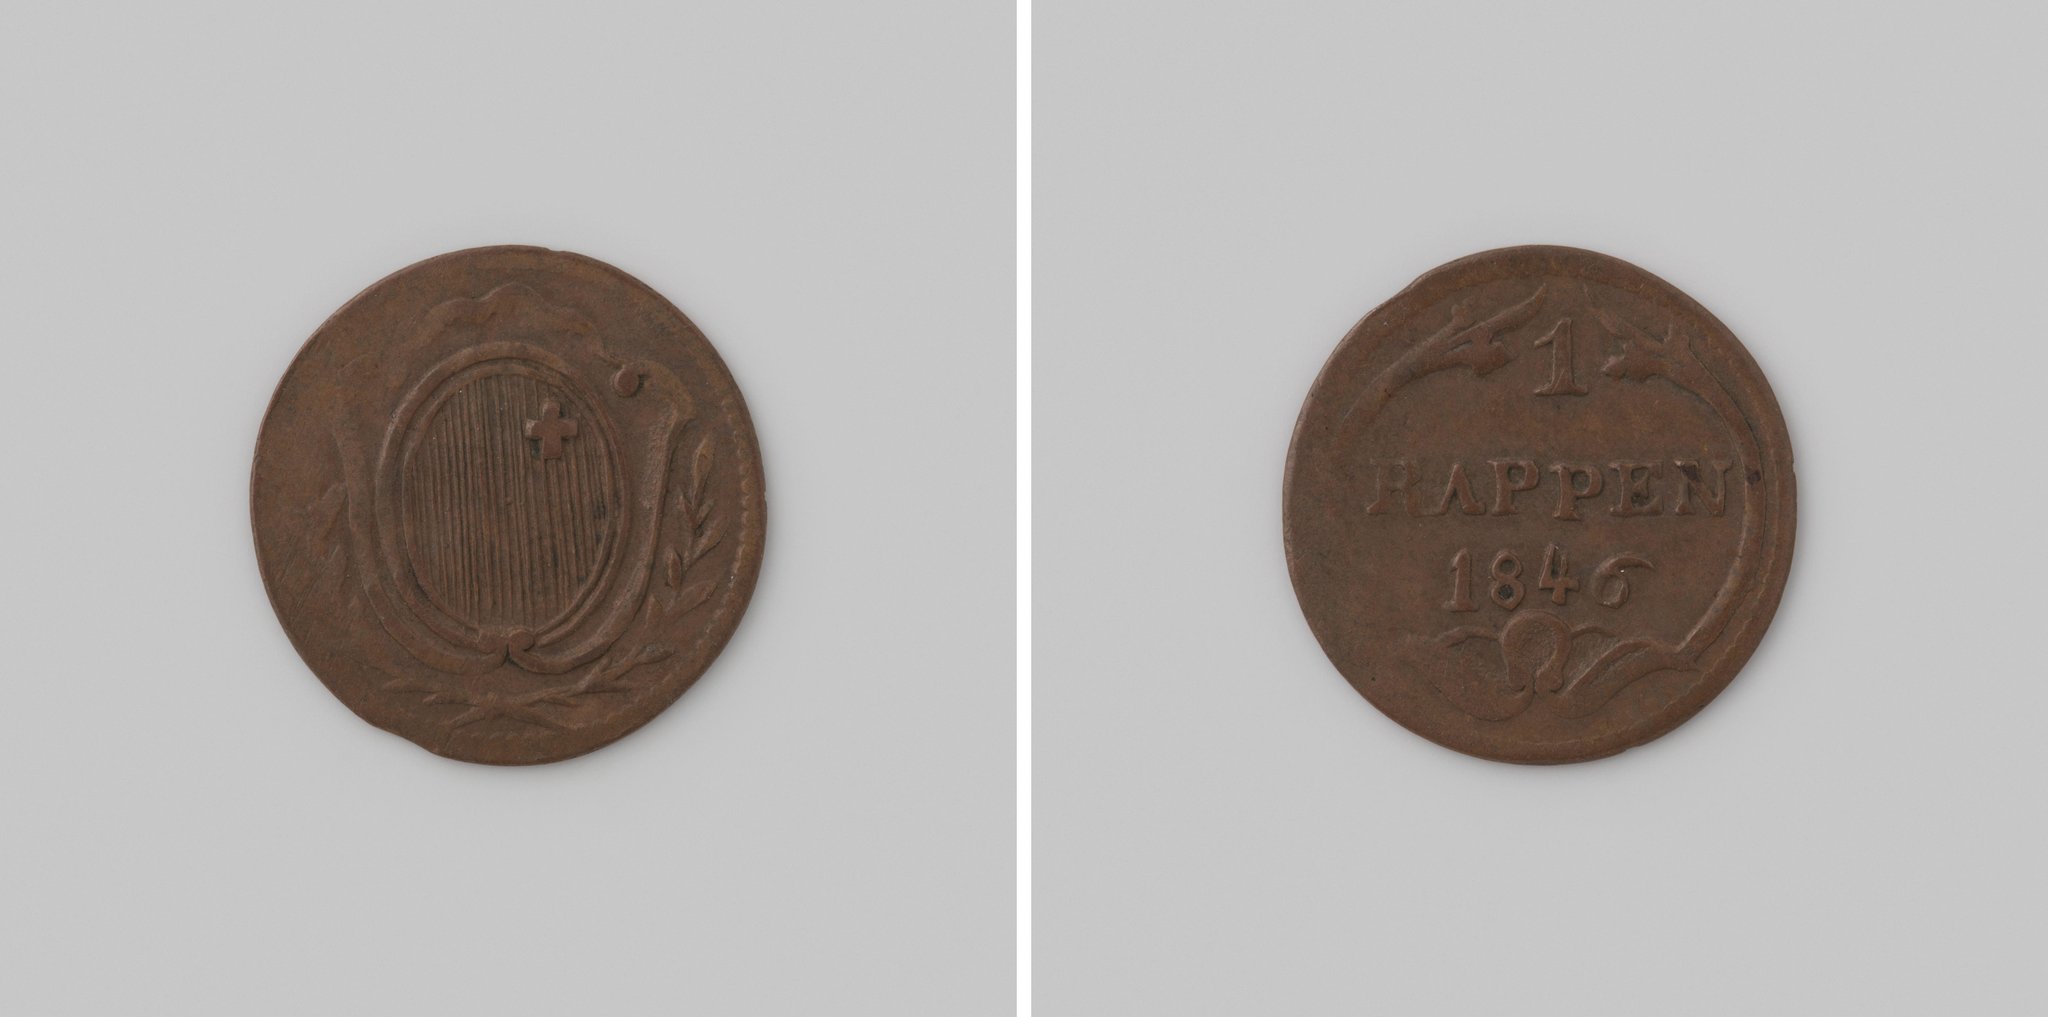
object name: coin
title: Kanton Schwyz, rappen, 1846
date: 1846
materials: copper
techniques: striking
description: Koperen munt. Voorzijde: binnen twee takken versierd wapenschild. Keerzijde: binnen barok-versiering in twee regels waarde-aanduiding, waaronder jaartal. Gladde rand.